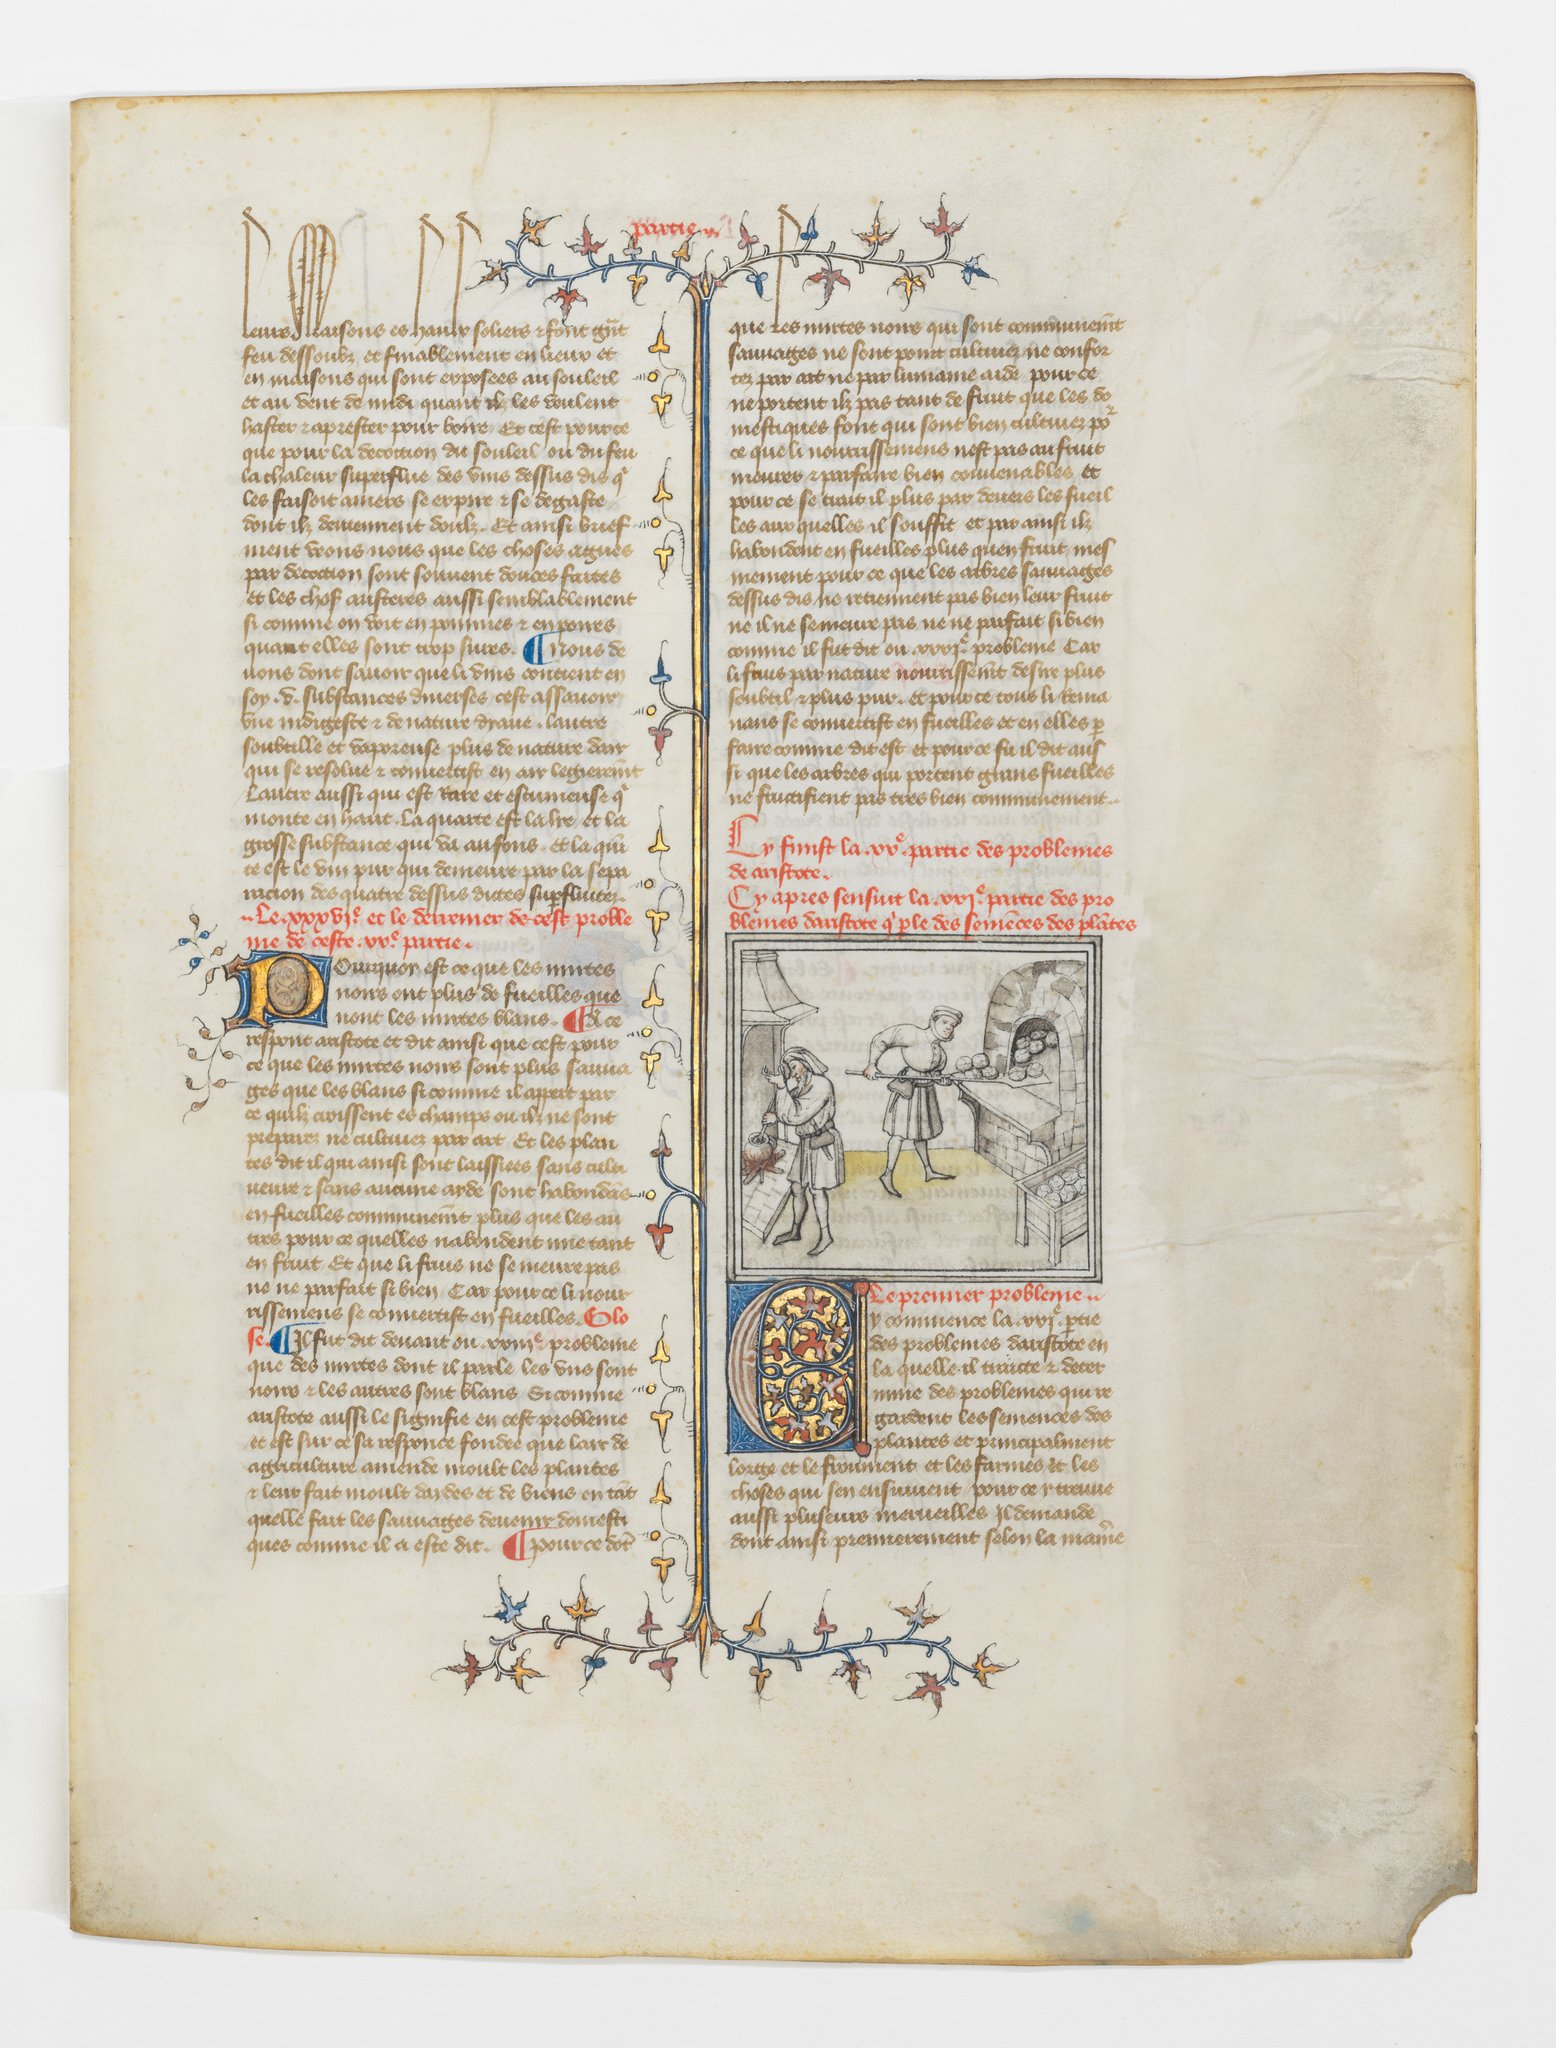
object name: bifolium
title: A Medieval Bakery, from the Book of Problems of Pseudo-Aristotle, translated into the French by Évrart de Conty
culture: french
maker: master of the second roman de la rose of the duke of berry,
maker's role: artist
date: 1400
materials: gold, ink, parchment